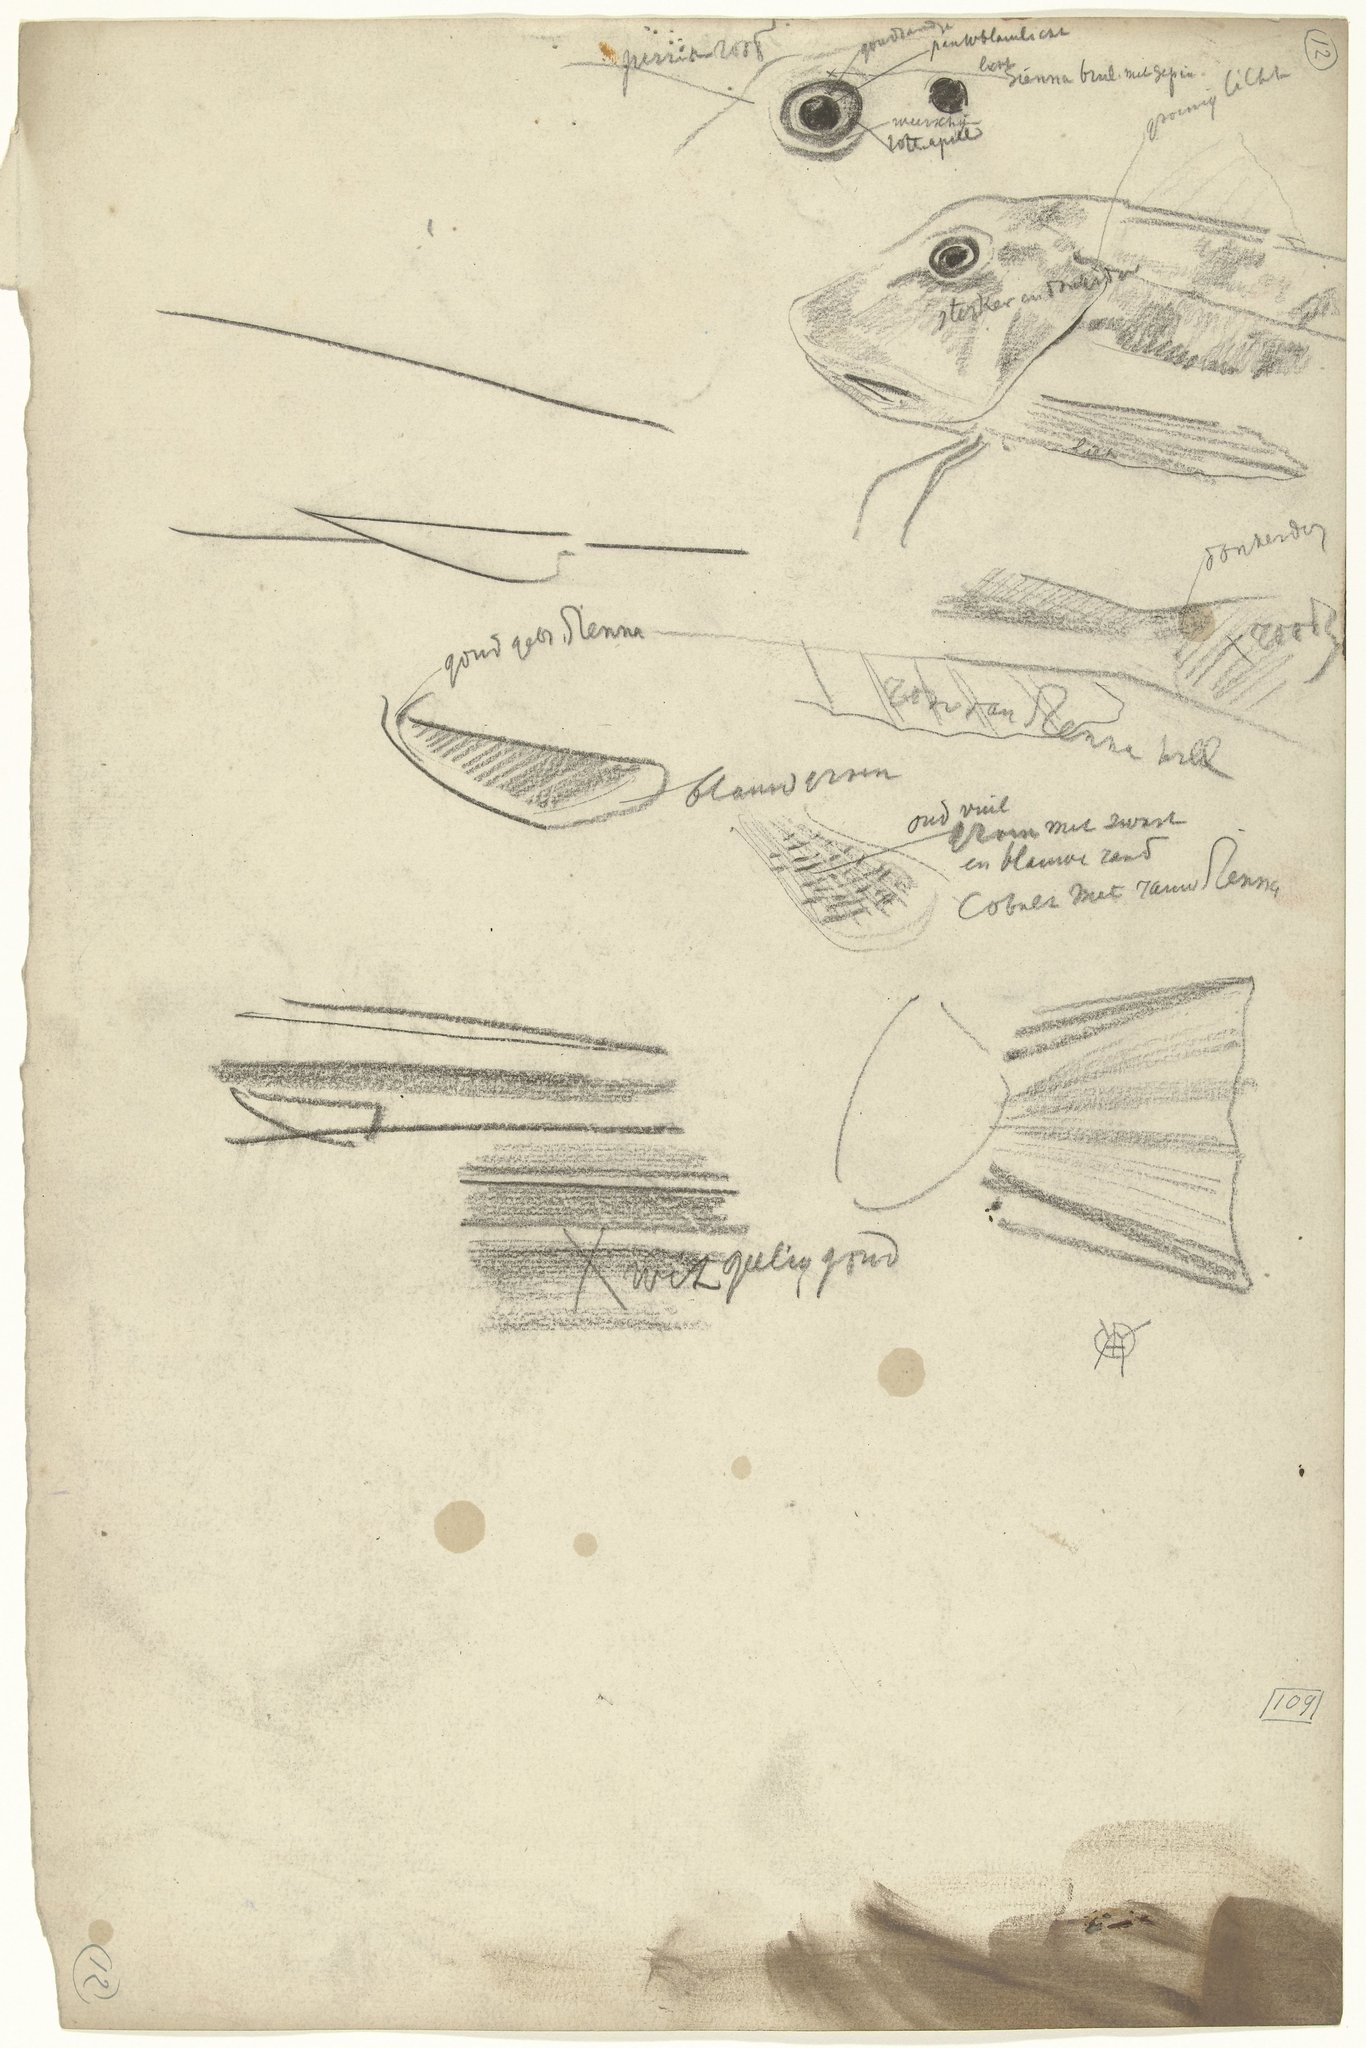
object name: drawing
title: Detailstudies van een poon, met kleurnotities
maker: gerrit willem dijsselhof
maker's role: designer, draughtsman, print maker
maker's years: 1866-1924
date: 1876-1924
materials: chalk, paper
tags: bony fishes: gurnard